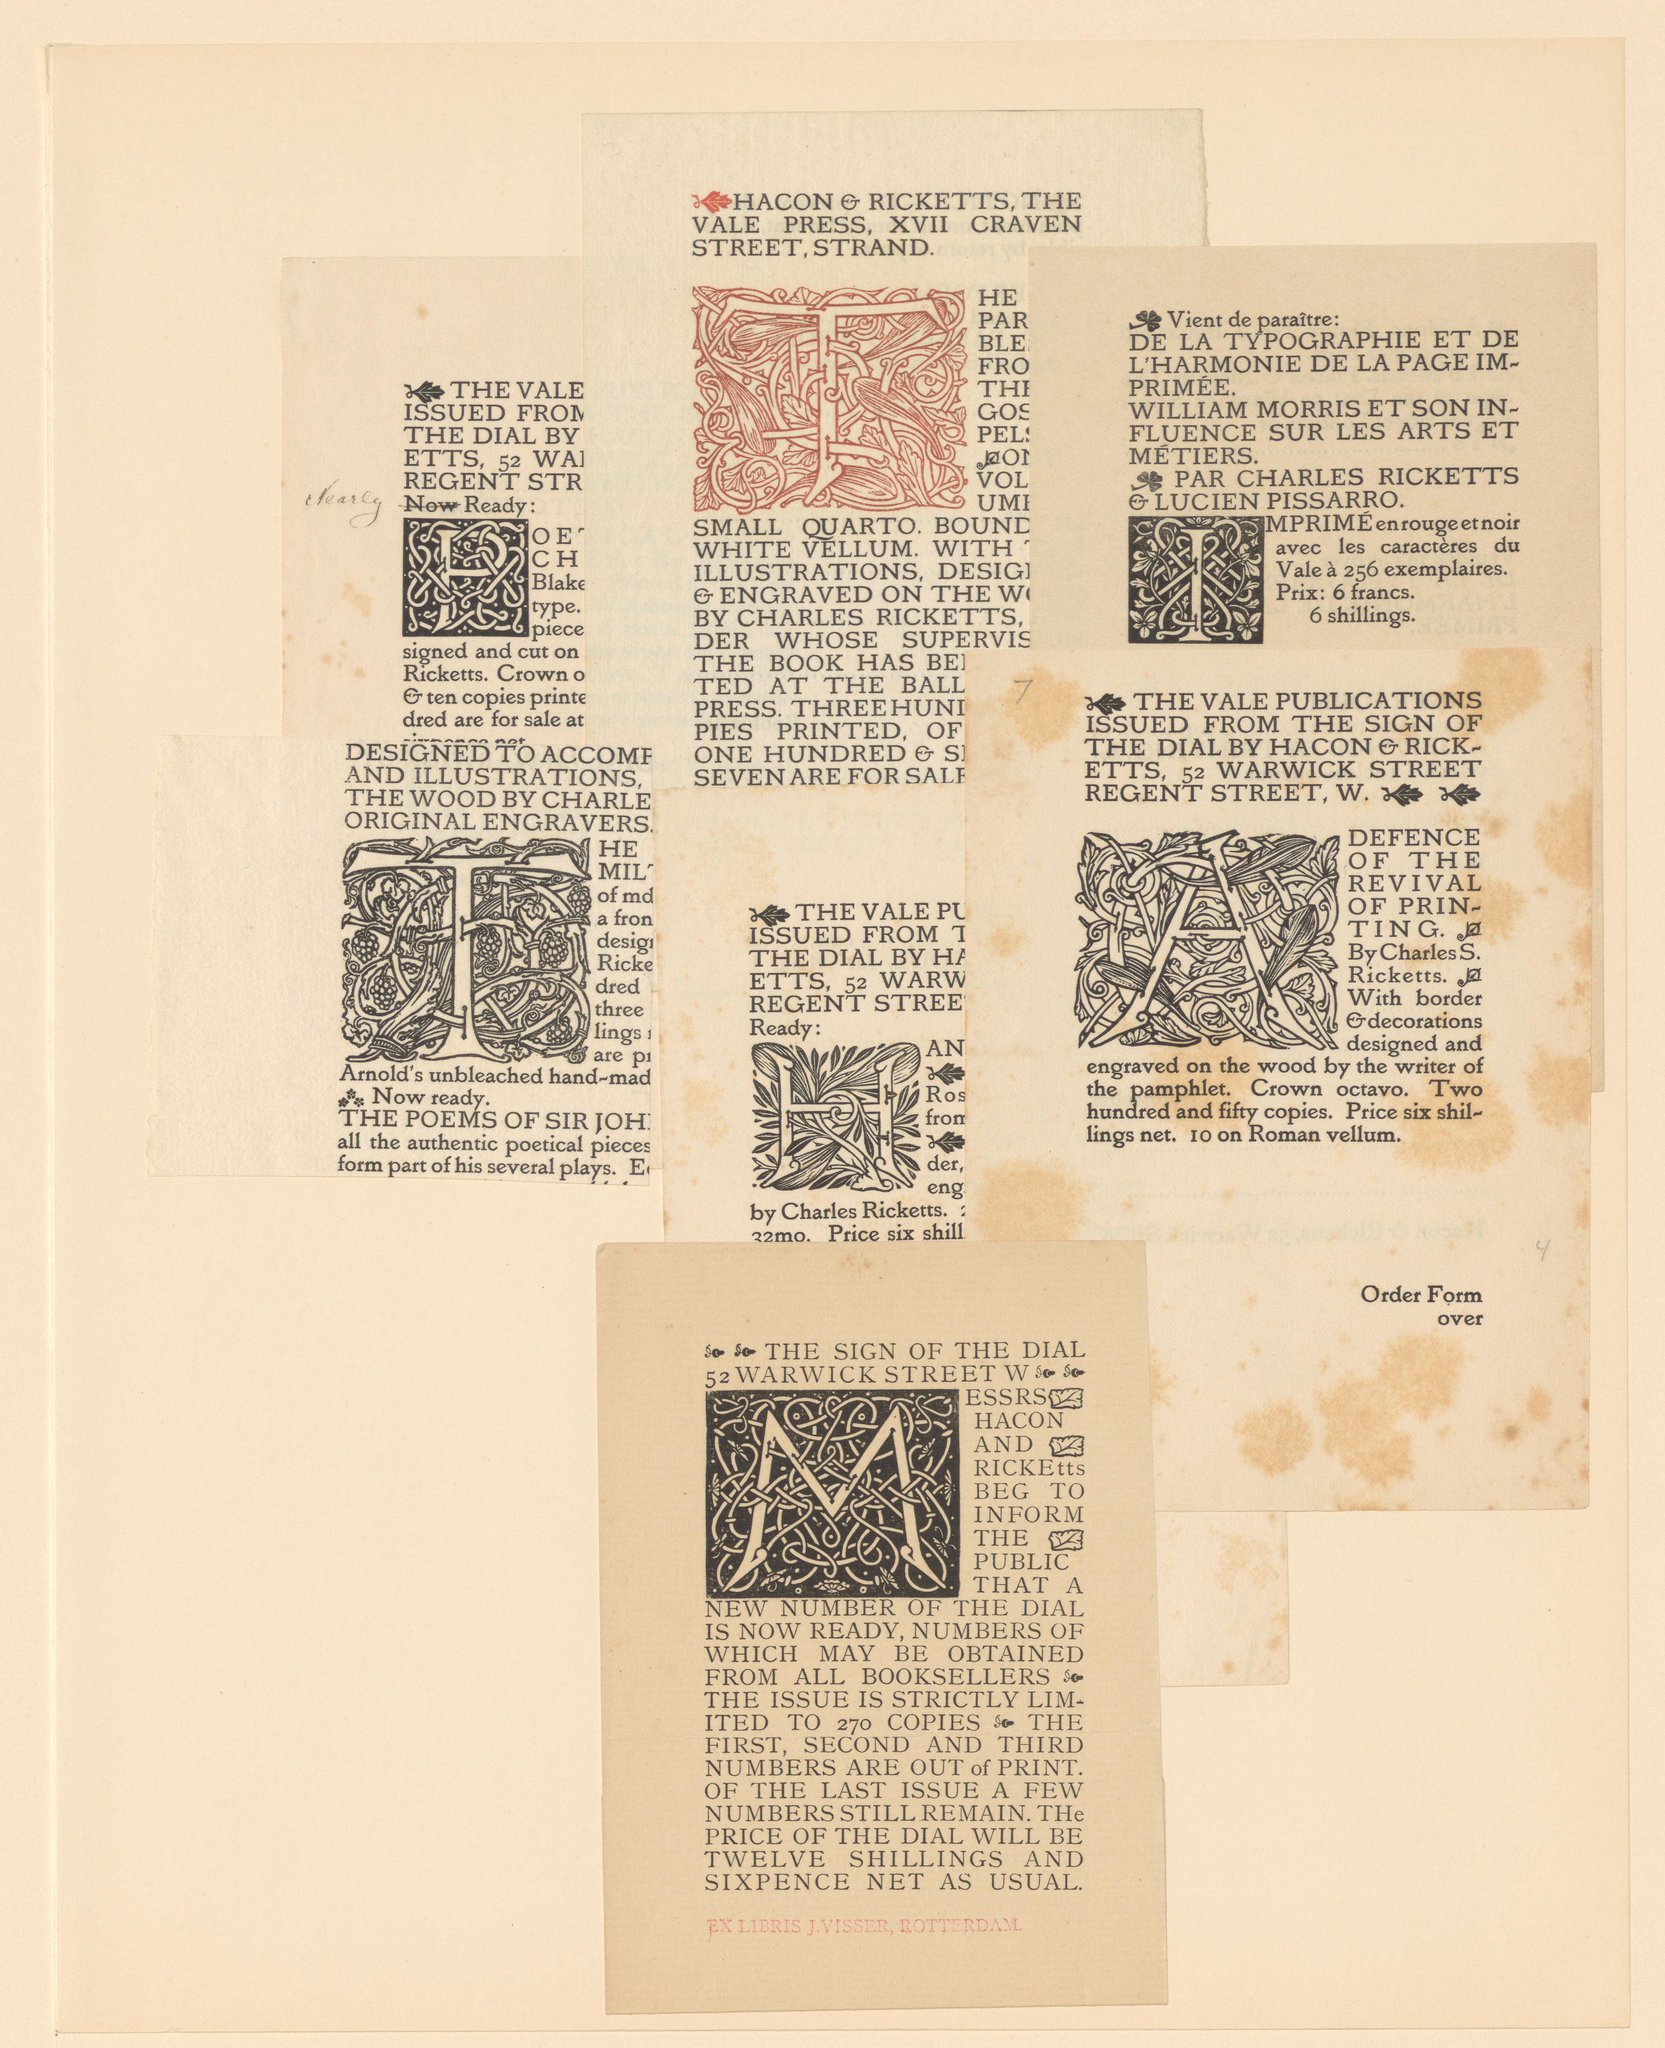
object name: print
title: Tekstblad met initiaal I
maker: charles ricketts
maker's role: print maker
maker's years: 1866-1931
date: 1898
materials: paper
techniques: letterpress printing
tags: initial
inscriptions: mark: ‘Ex libris J. Visser, Rotterdam’, collector's mark: Lugt 2228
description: Deze prent is een advertentie met bestelformulier voor het werk 'De la typographie et de l'harmonie de la page imprimée. William Morris et son influence sur les arts et métiers' van Charles Ricketts en Lucien Pissarro uit 1898.